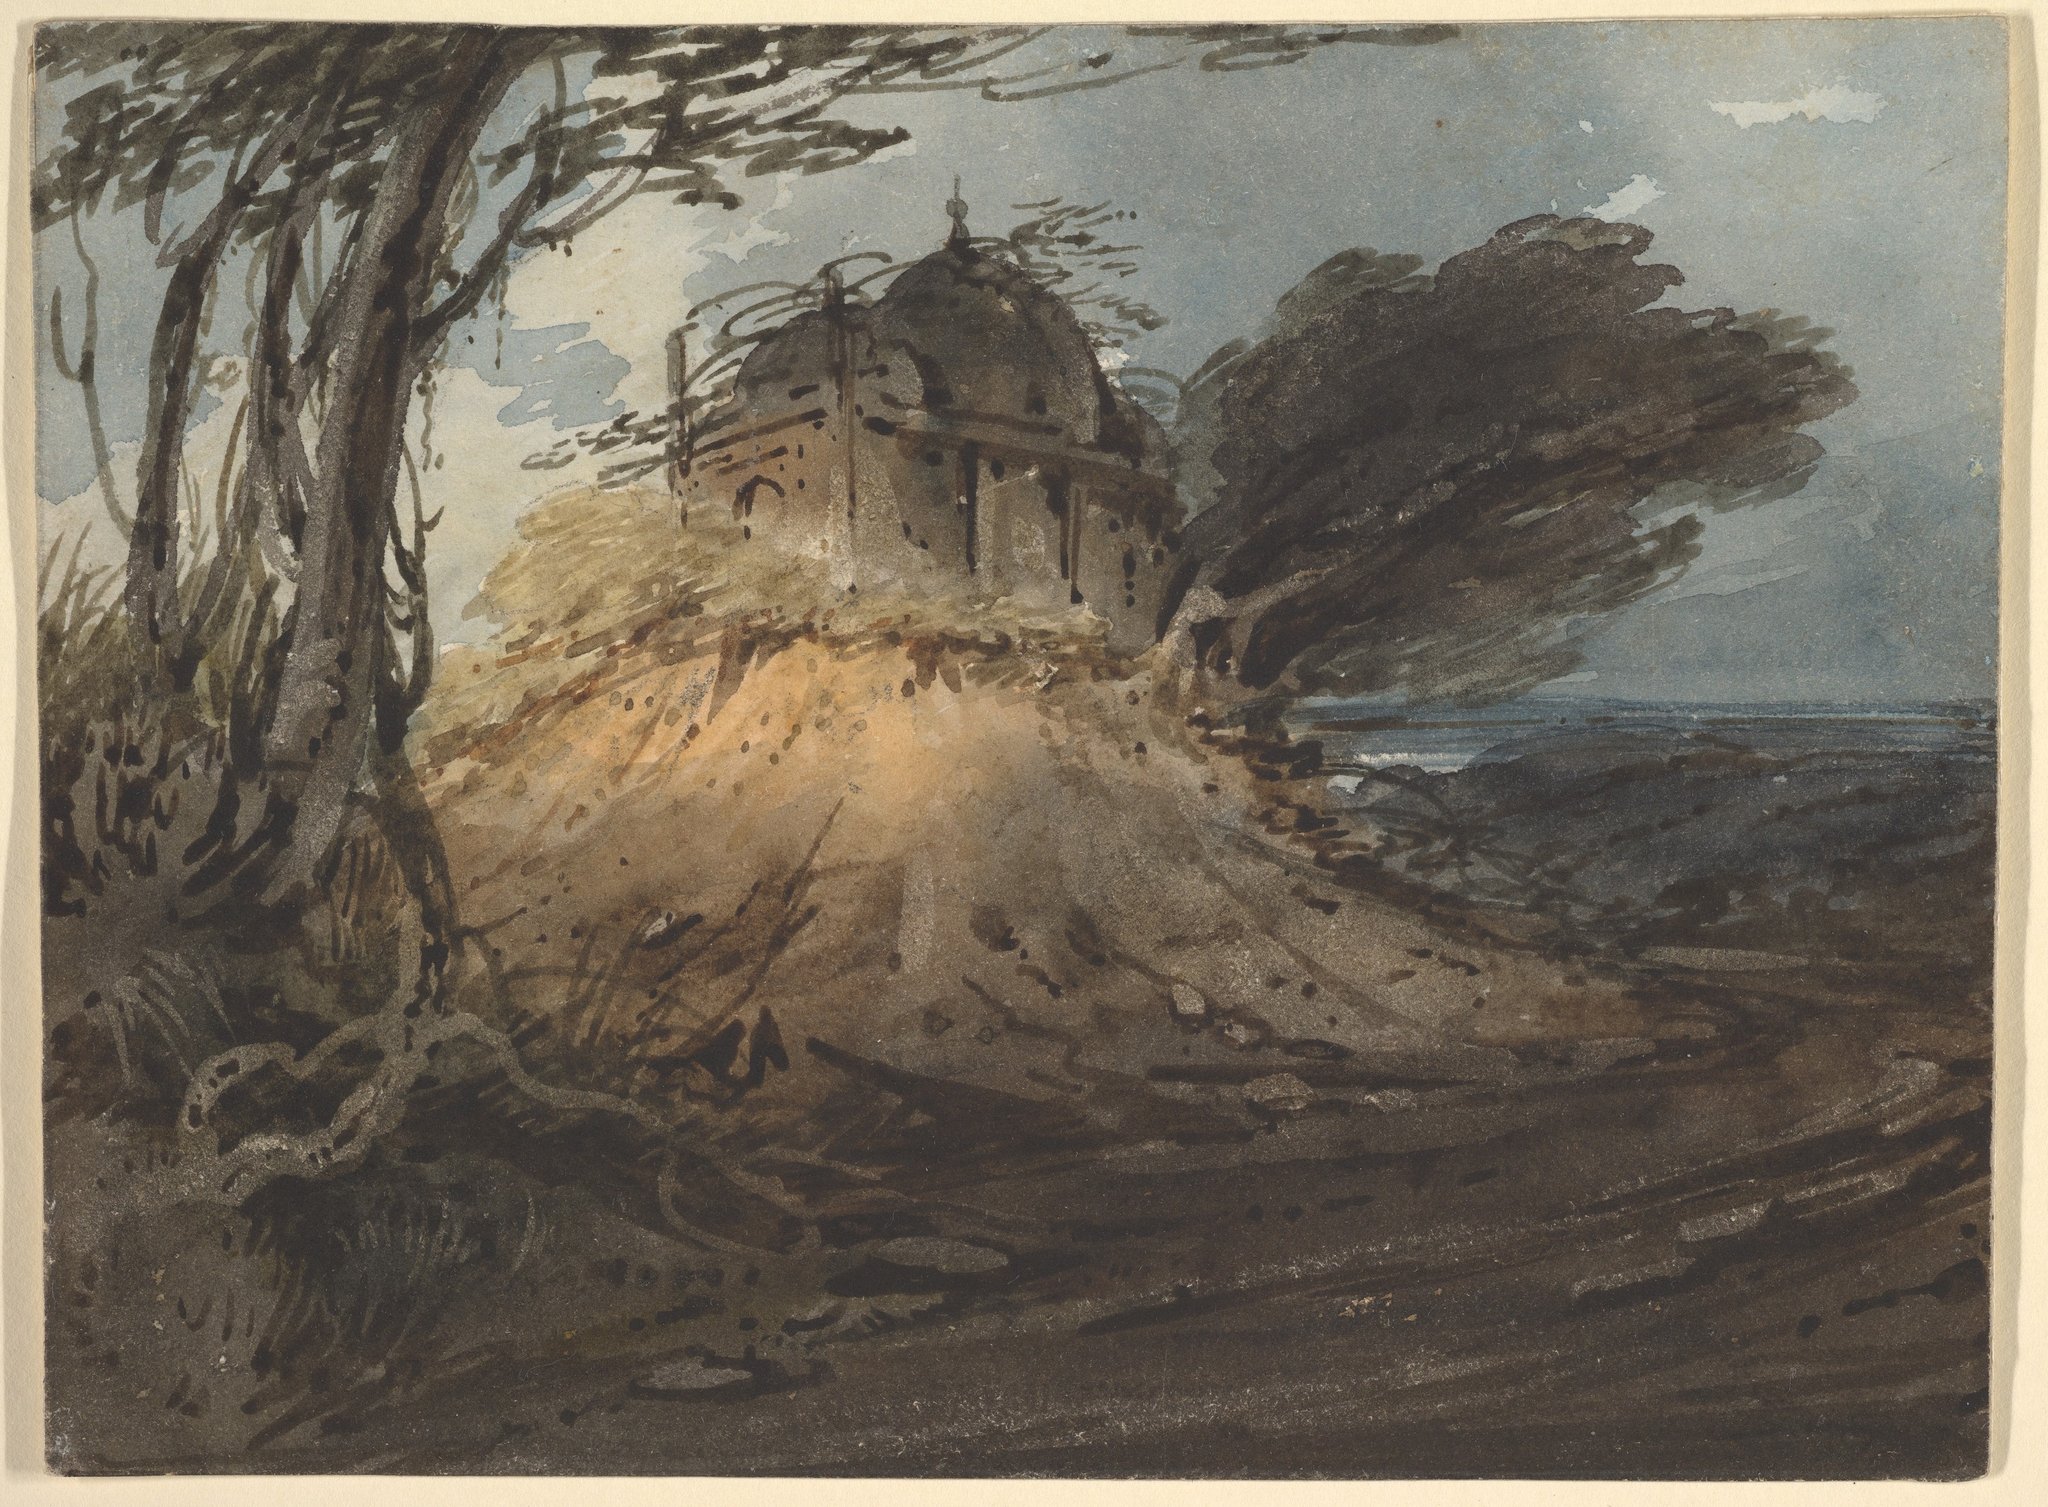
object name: drawing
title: Indian temple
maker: george chinnery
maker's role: artist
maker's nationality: british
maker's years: 1774-1852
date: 1808-1812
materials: watercolor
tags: temples